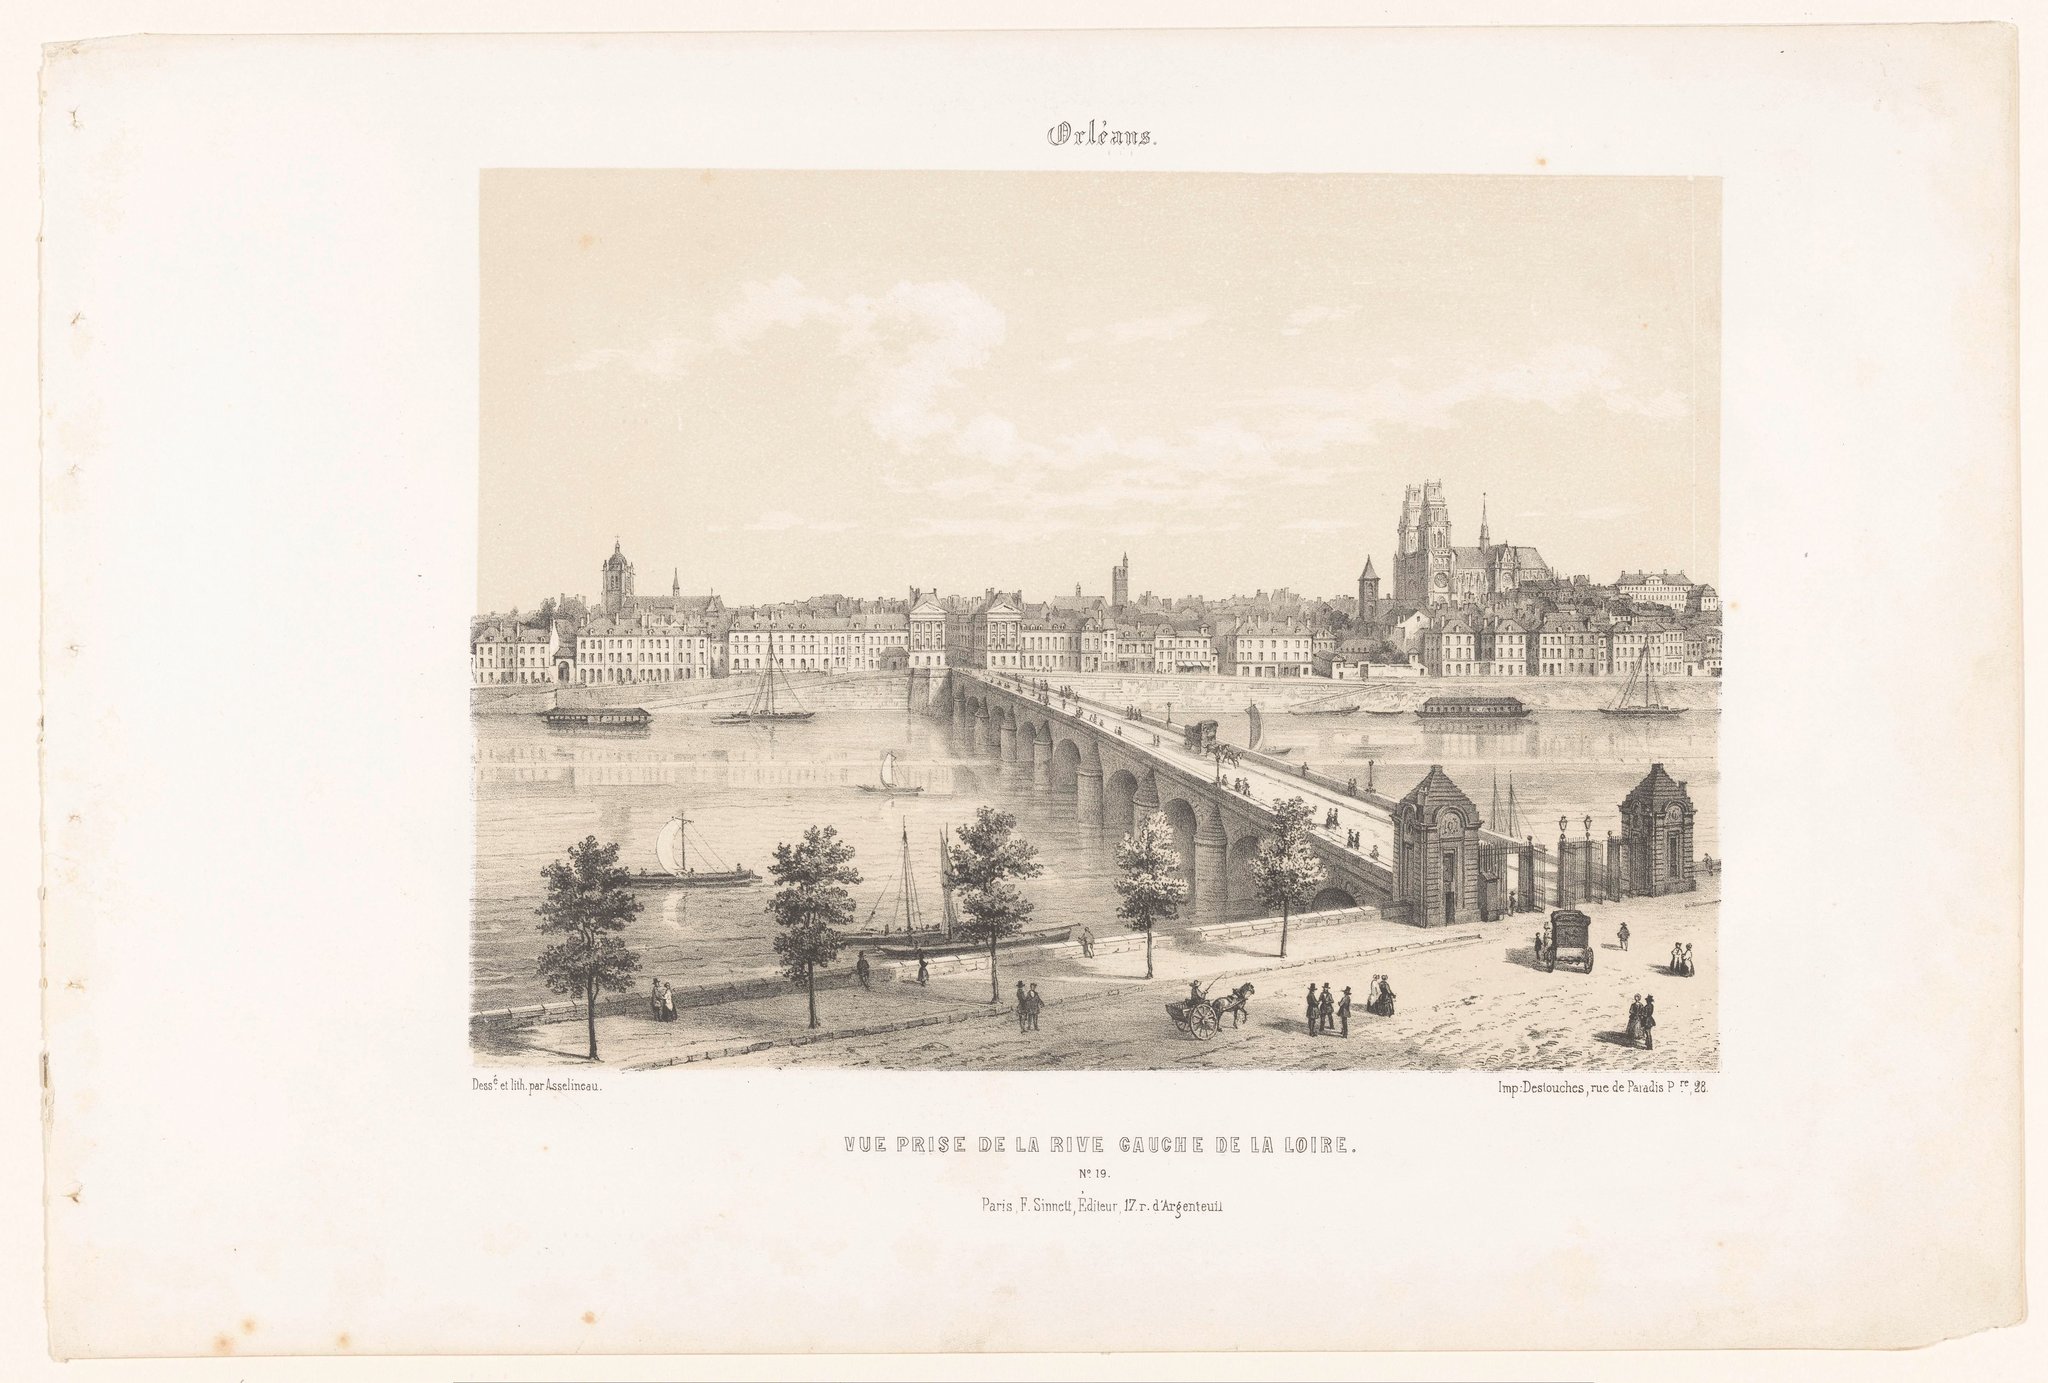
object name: print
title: Hedendaags Frankrijk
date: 1853-1856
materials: paper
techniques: tone lithography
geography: rouen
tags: bridge, bridge in city across river, canal, etc., prospect of city, town panorama, silhouette of city (+ city(-scape) with figures, staffage)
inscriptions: collector's mark: Lugt 2228